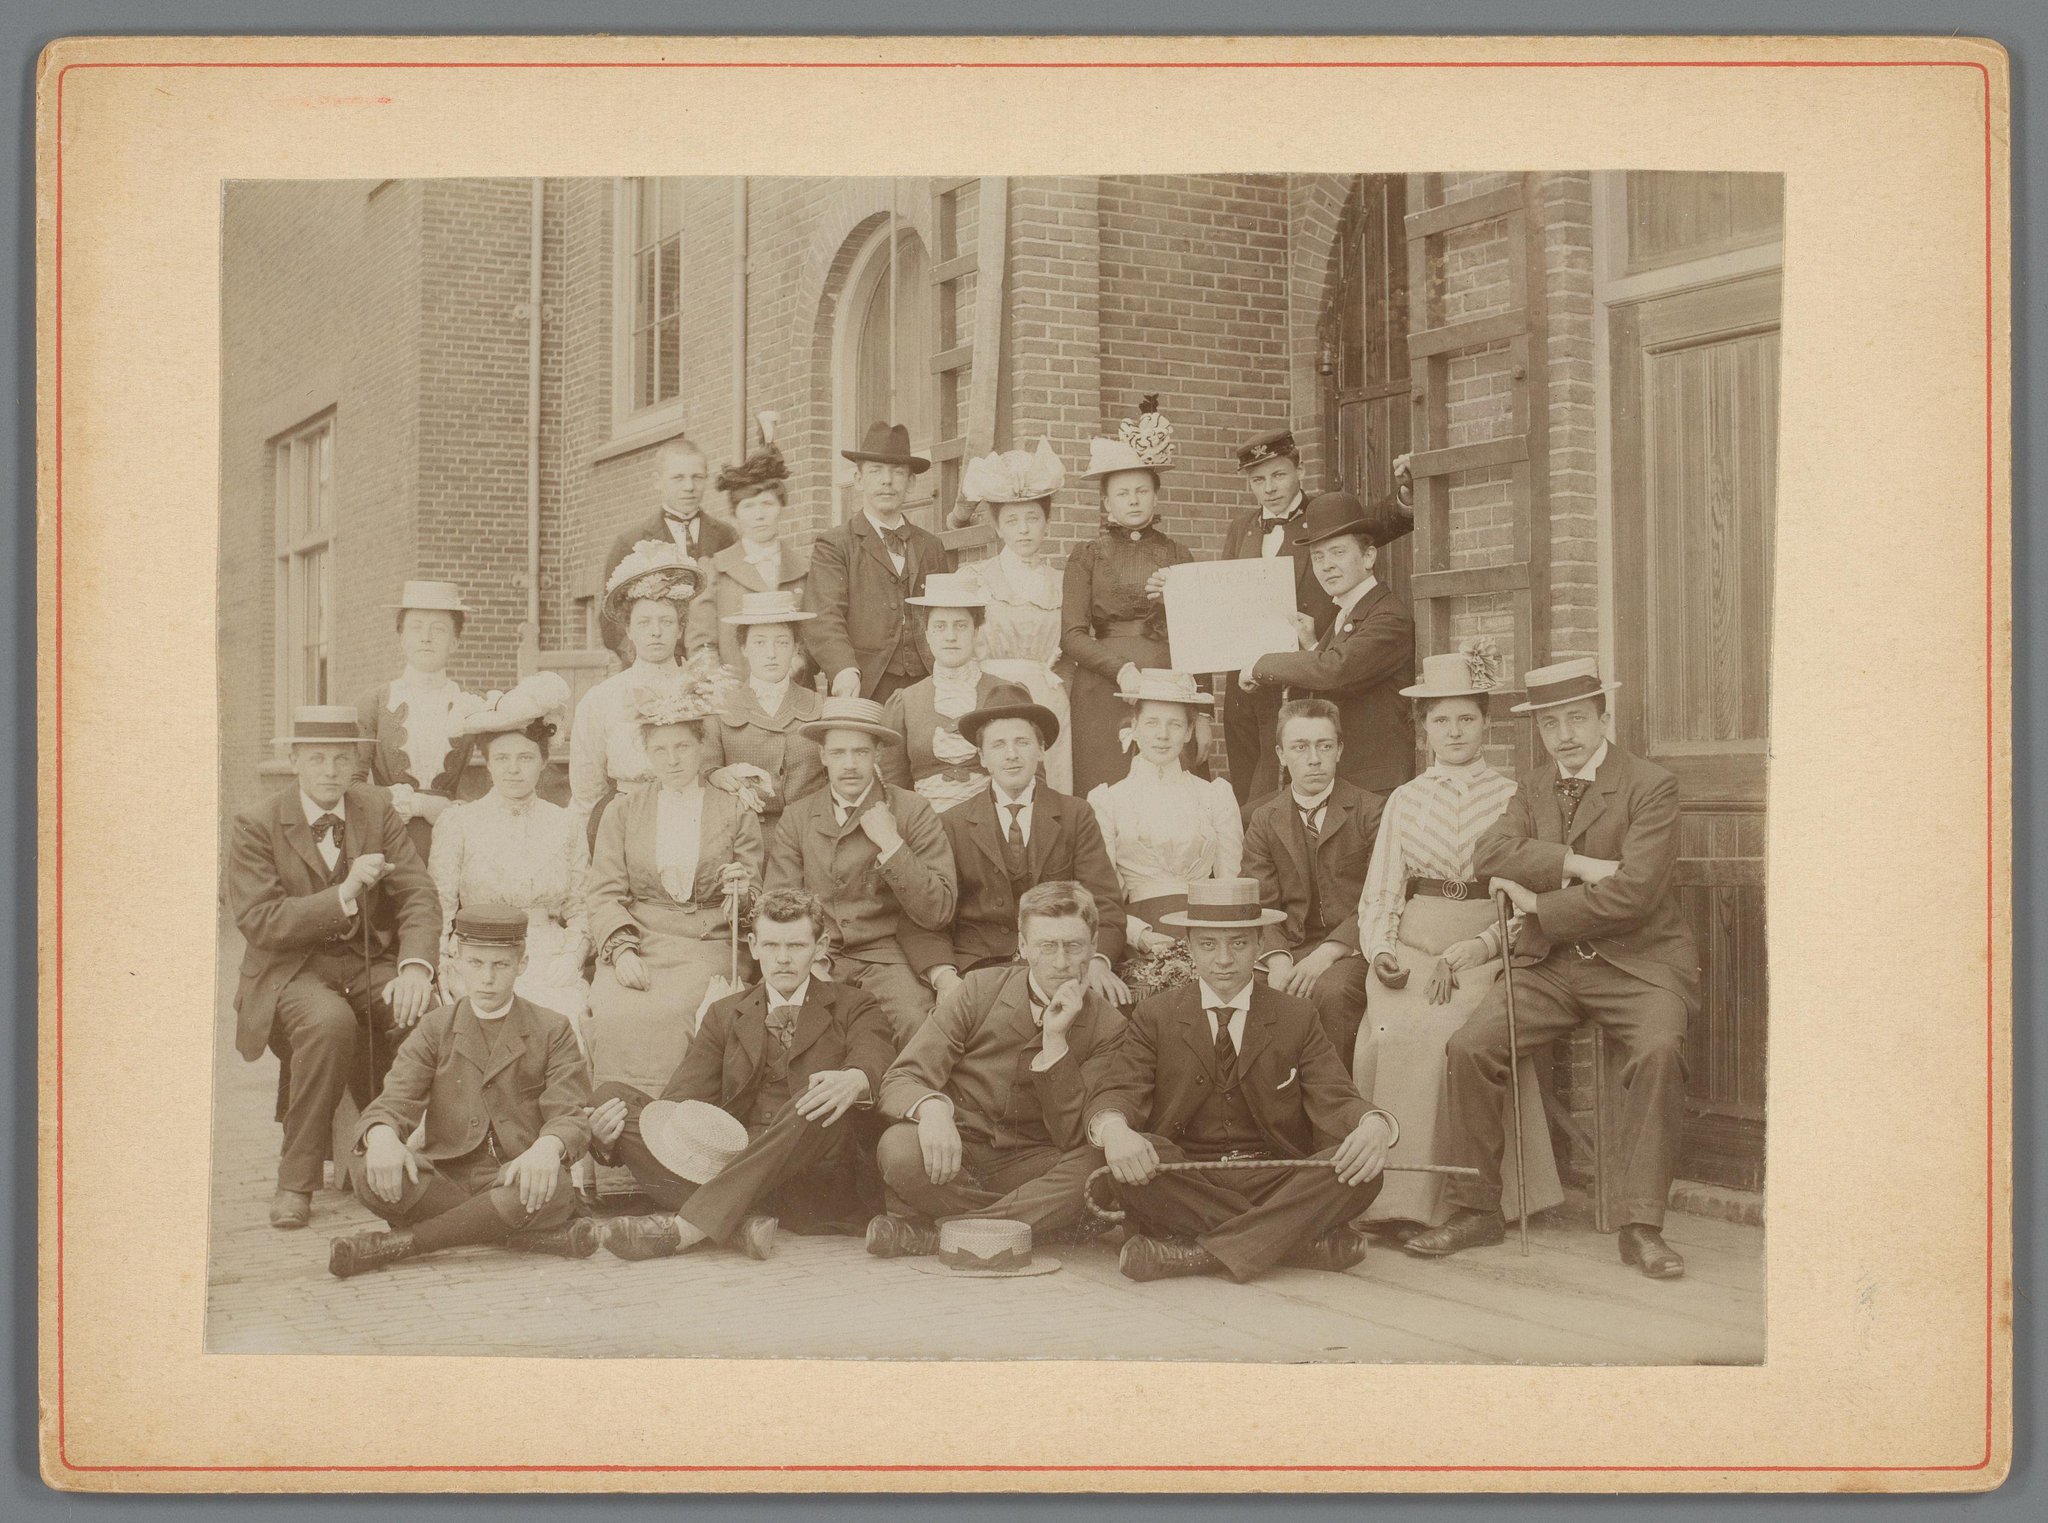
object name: photograph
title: Groepsportret van een groep jongeren, waaronder Jacob Olie junior, Jan Olie, Aagje en Willem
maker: Anonymous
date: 1900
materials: paper, cardboard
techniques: collodion silver print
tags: amsterdam, jacob olie jr., historical persons, bicycle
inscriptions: inscription: ‘De Veertien + X’, inscription: ‘l.b. Willem/ Jacob boven/ Jan midden, daarnaast/ Aagje/ jongerenreis 'De Veertien X'/ UIBW (uitgenodigd op een/ [...]/ stalhouderij A/d [...] c. 1900’